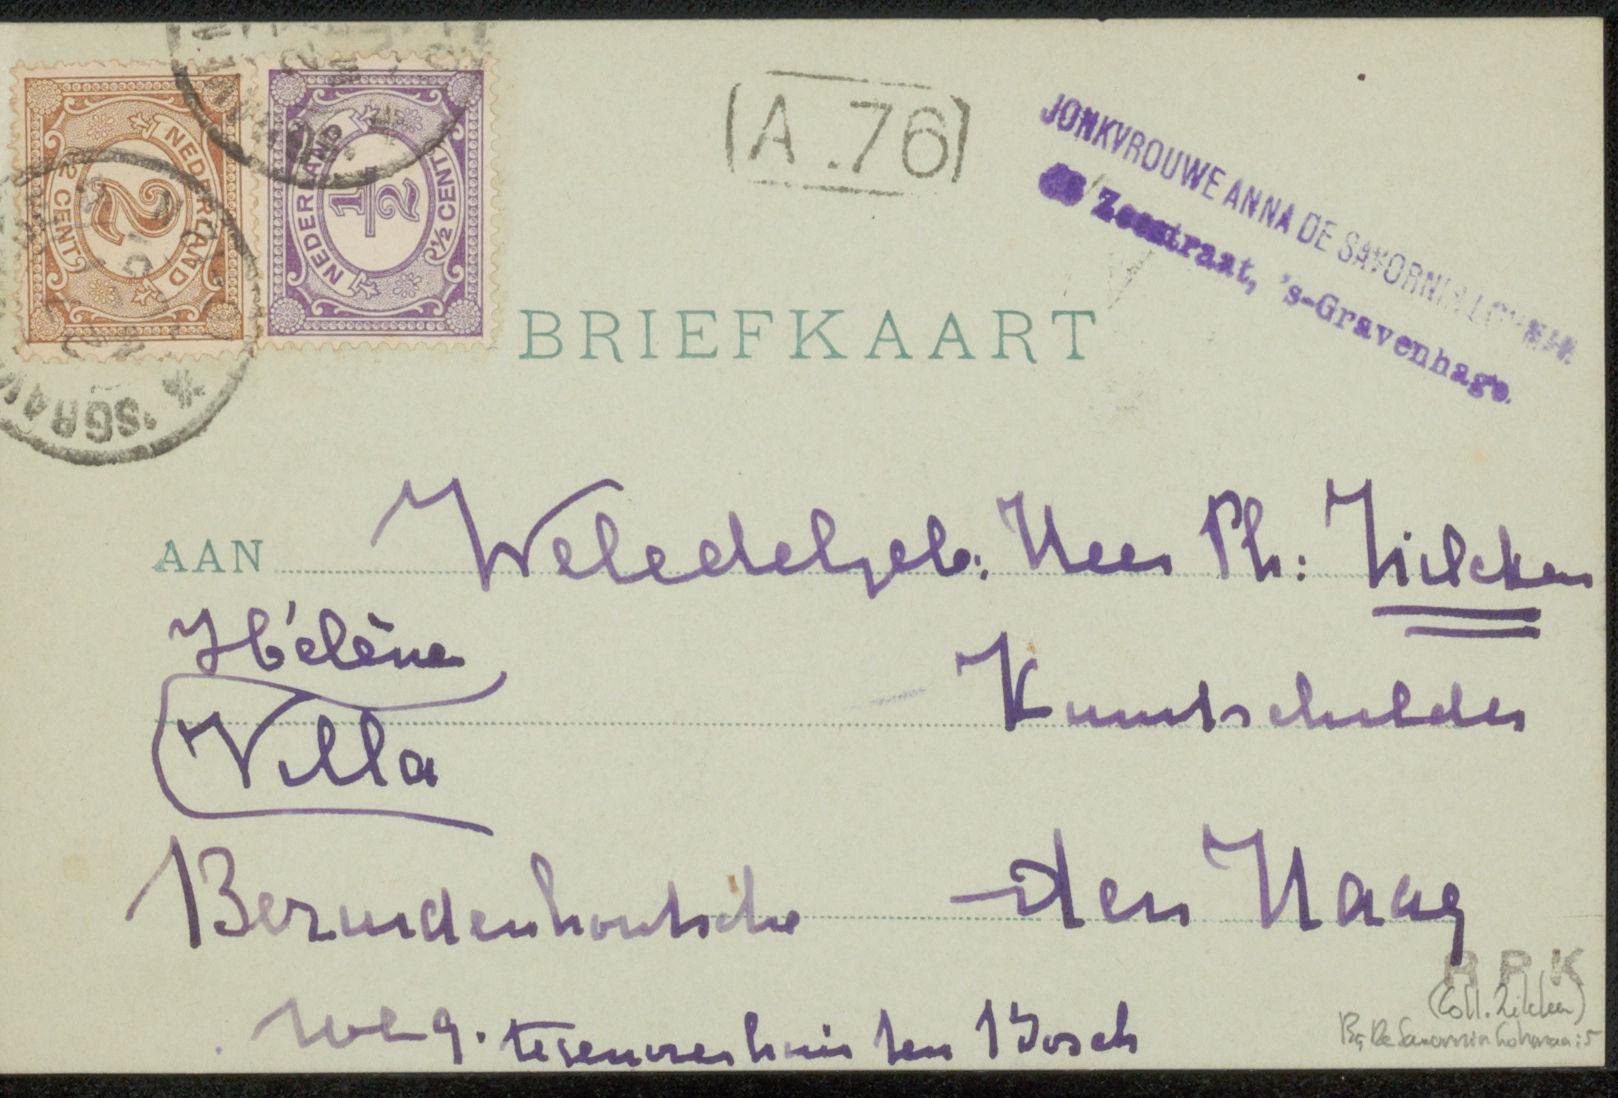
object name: postcard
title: Briefkaart aan Philip Zilcken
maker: jonkvrouw catharina anna maria de savornin lohman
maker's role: criticus, journalist, schrijver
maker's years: 1868-1930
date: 1903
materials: cardboard, ink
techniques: pen, writing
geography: the hague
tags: the hague, painter, philip zilcken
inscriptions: name: ‘JONKVROUWE ANNA DE SAVORNIN LOHMAN/ de Zeestraat, 's-Gravenhage.’, collector's mark: ‘RPK’